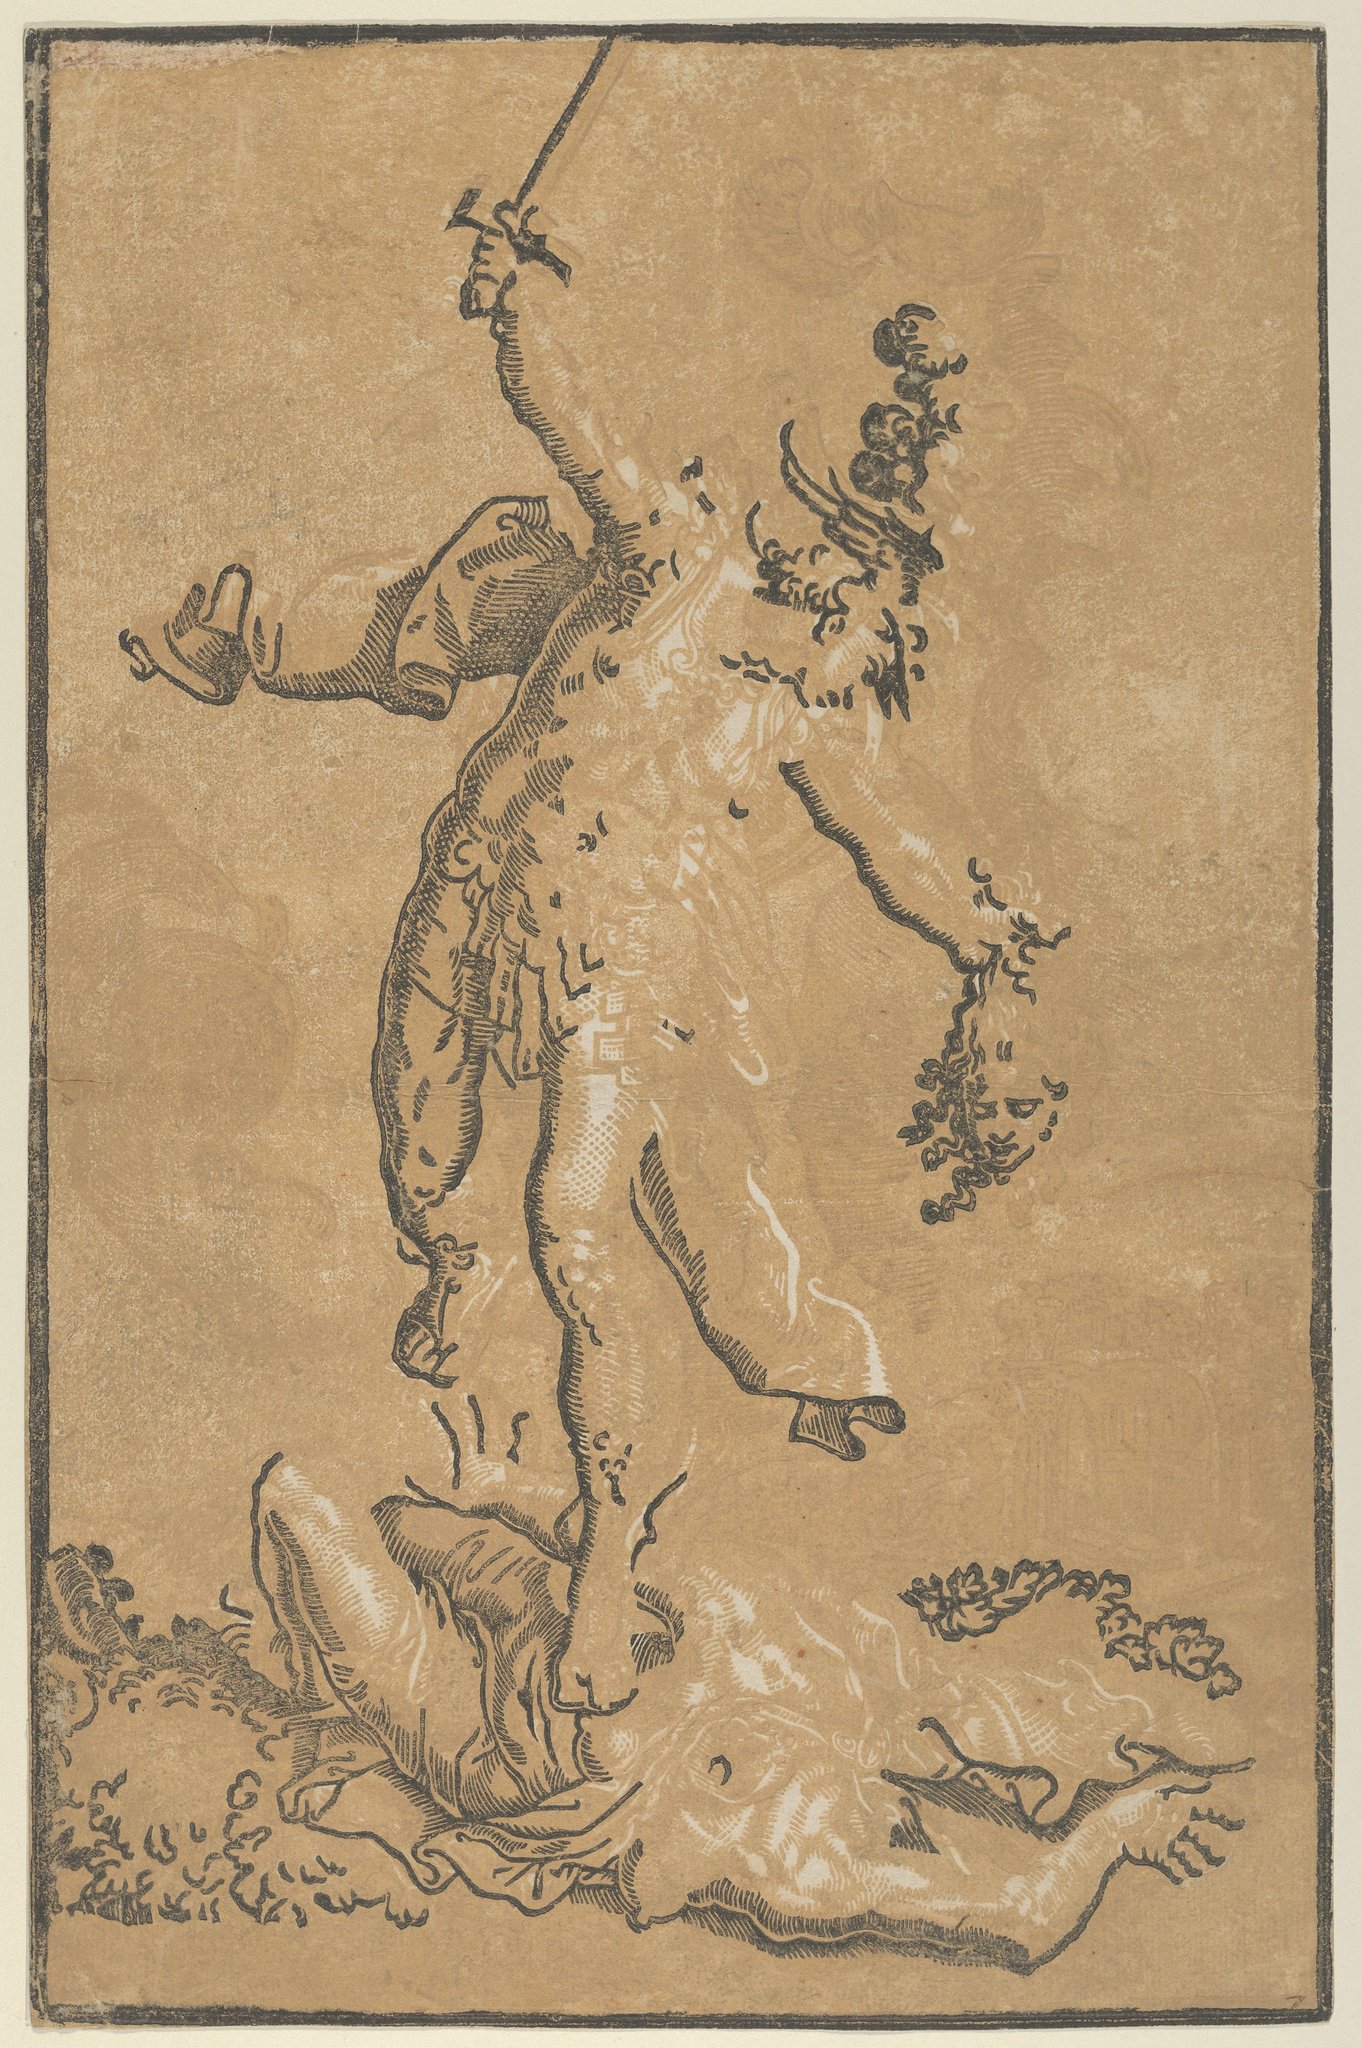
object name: print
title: Perseus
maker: antonio spano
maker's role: artist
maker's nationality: italian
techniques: woodcut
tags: perseus